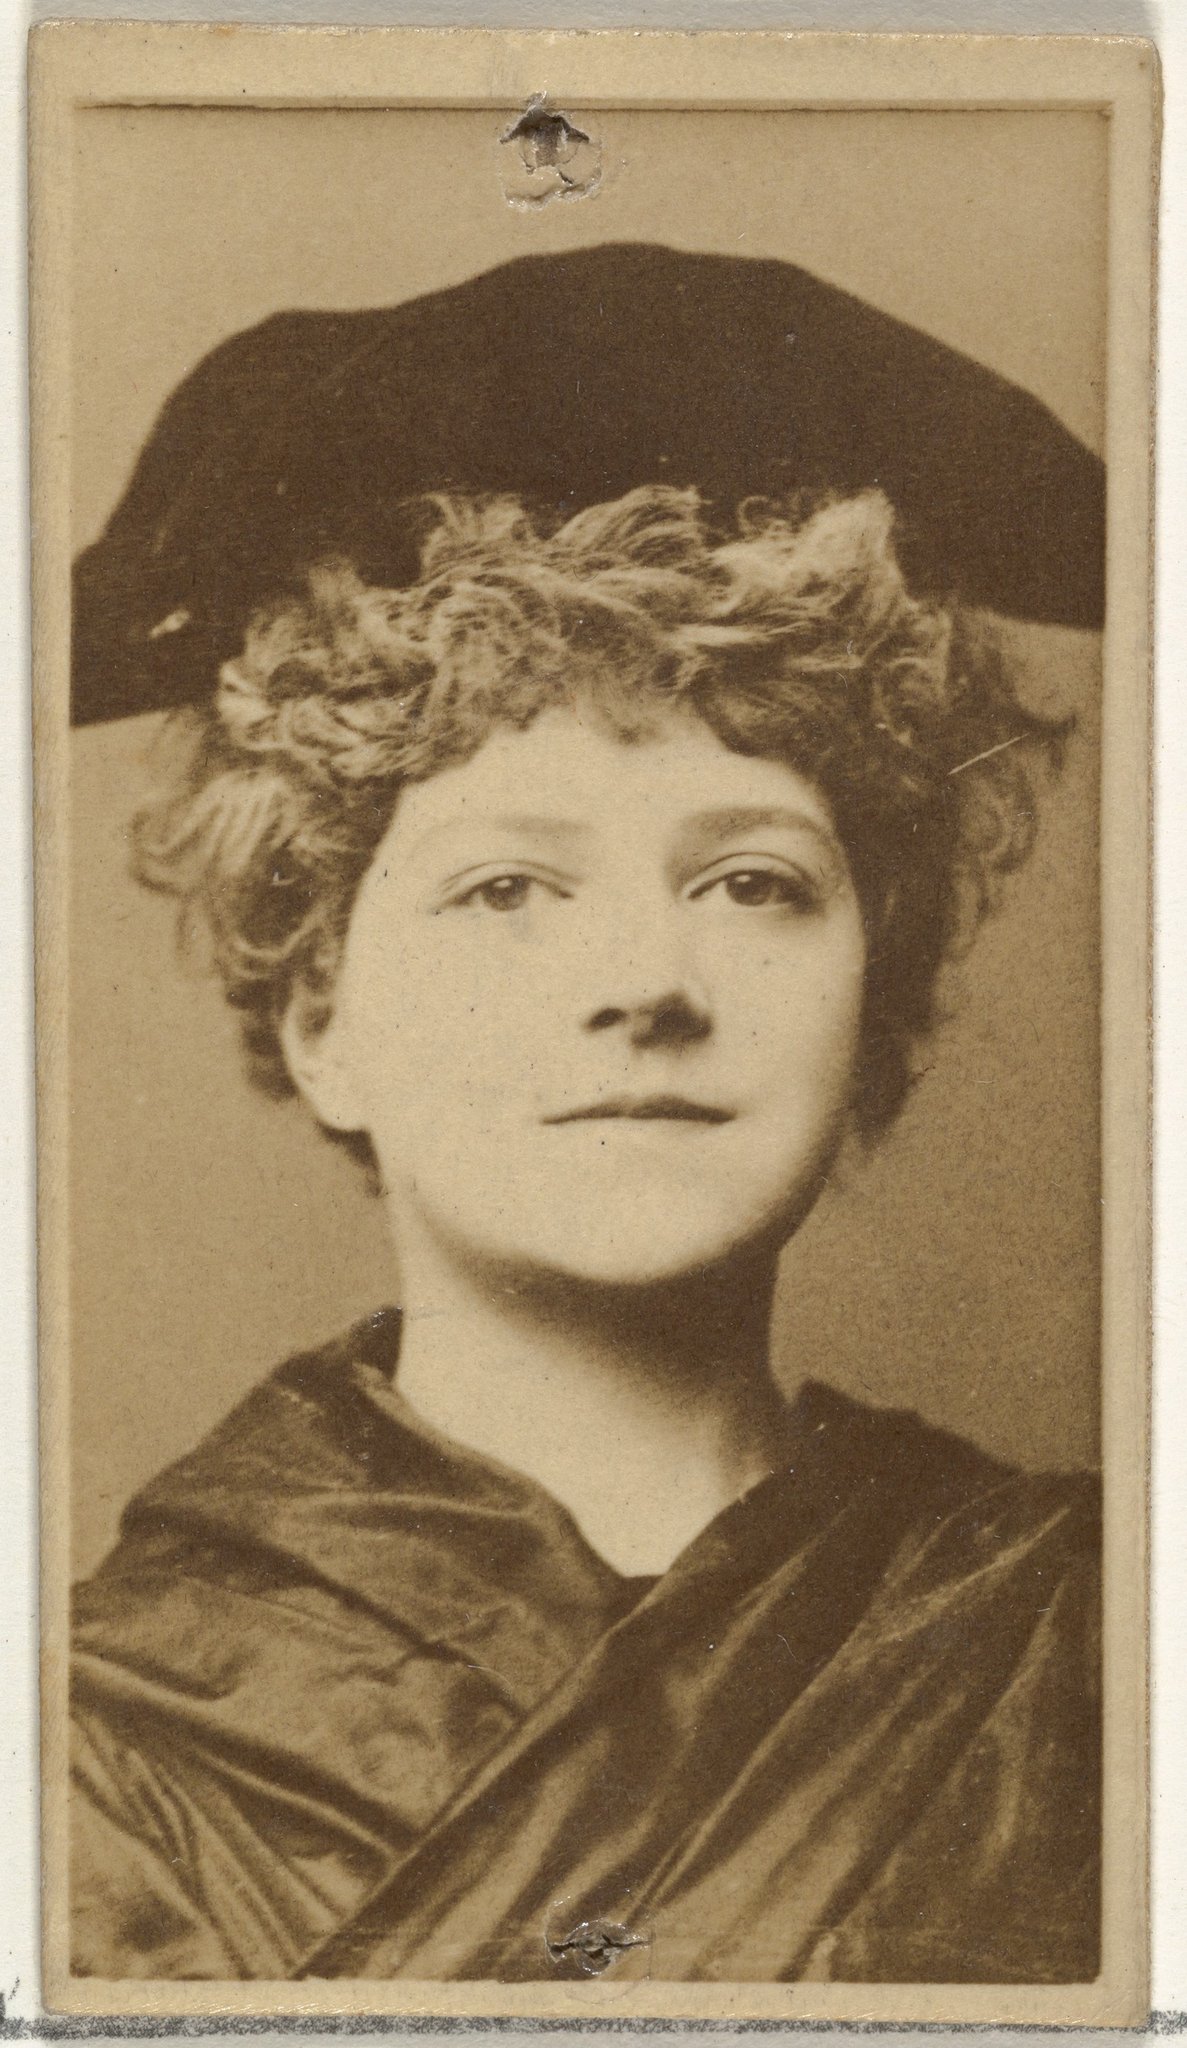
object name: photograph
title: [Actress wearing dark cloth cap], from the Actors and Actresses series (N145-8) issued by Duke Sons & Co. to promote Duke Cigarettes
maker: w. duke, sons & co.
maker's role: publisher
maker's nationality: american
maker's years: 1870-1920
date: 1891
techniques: albumen silver print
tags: portraits,women,actresses